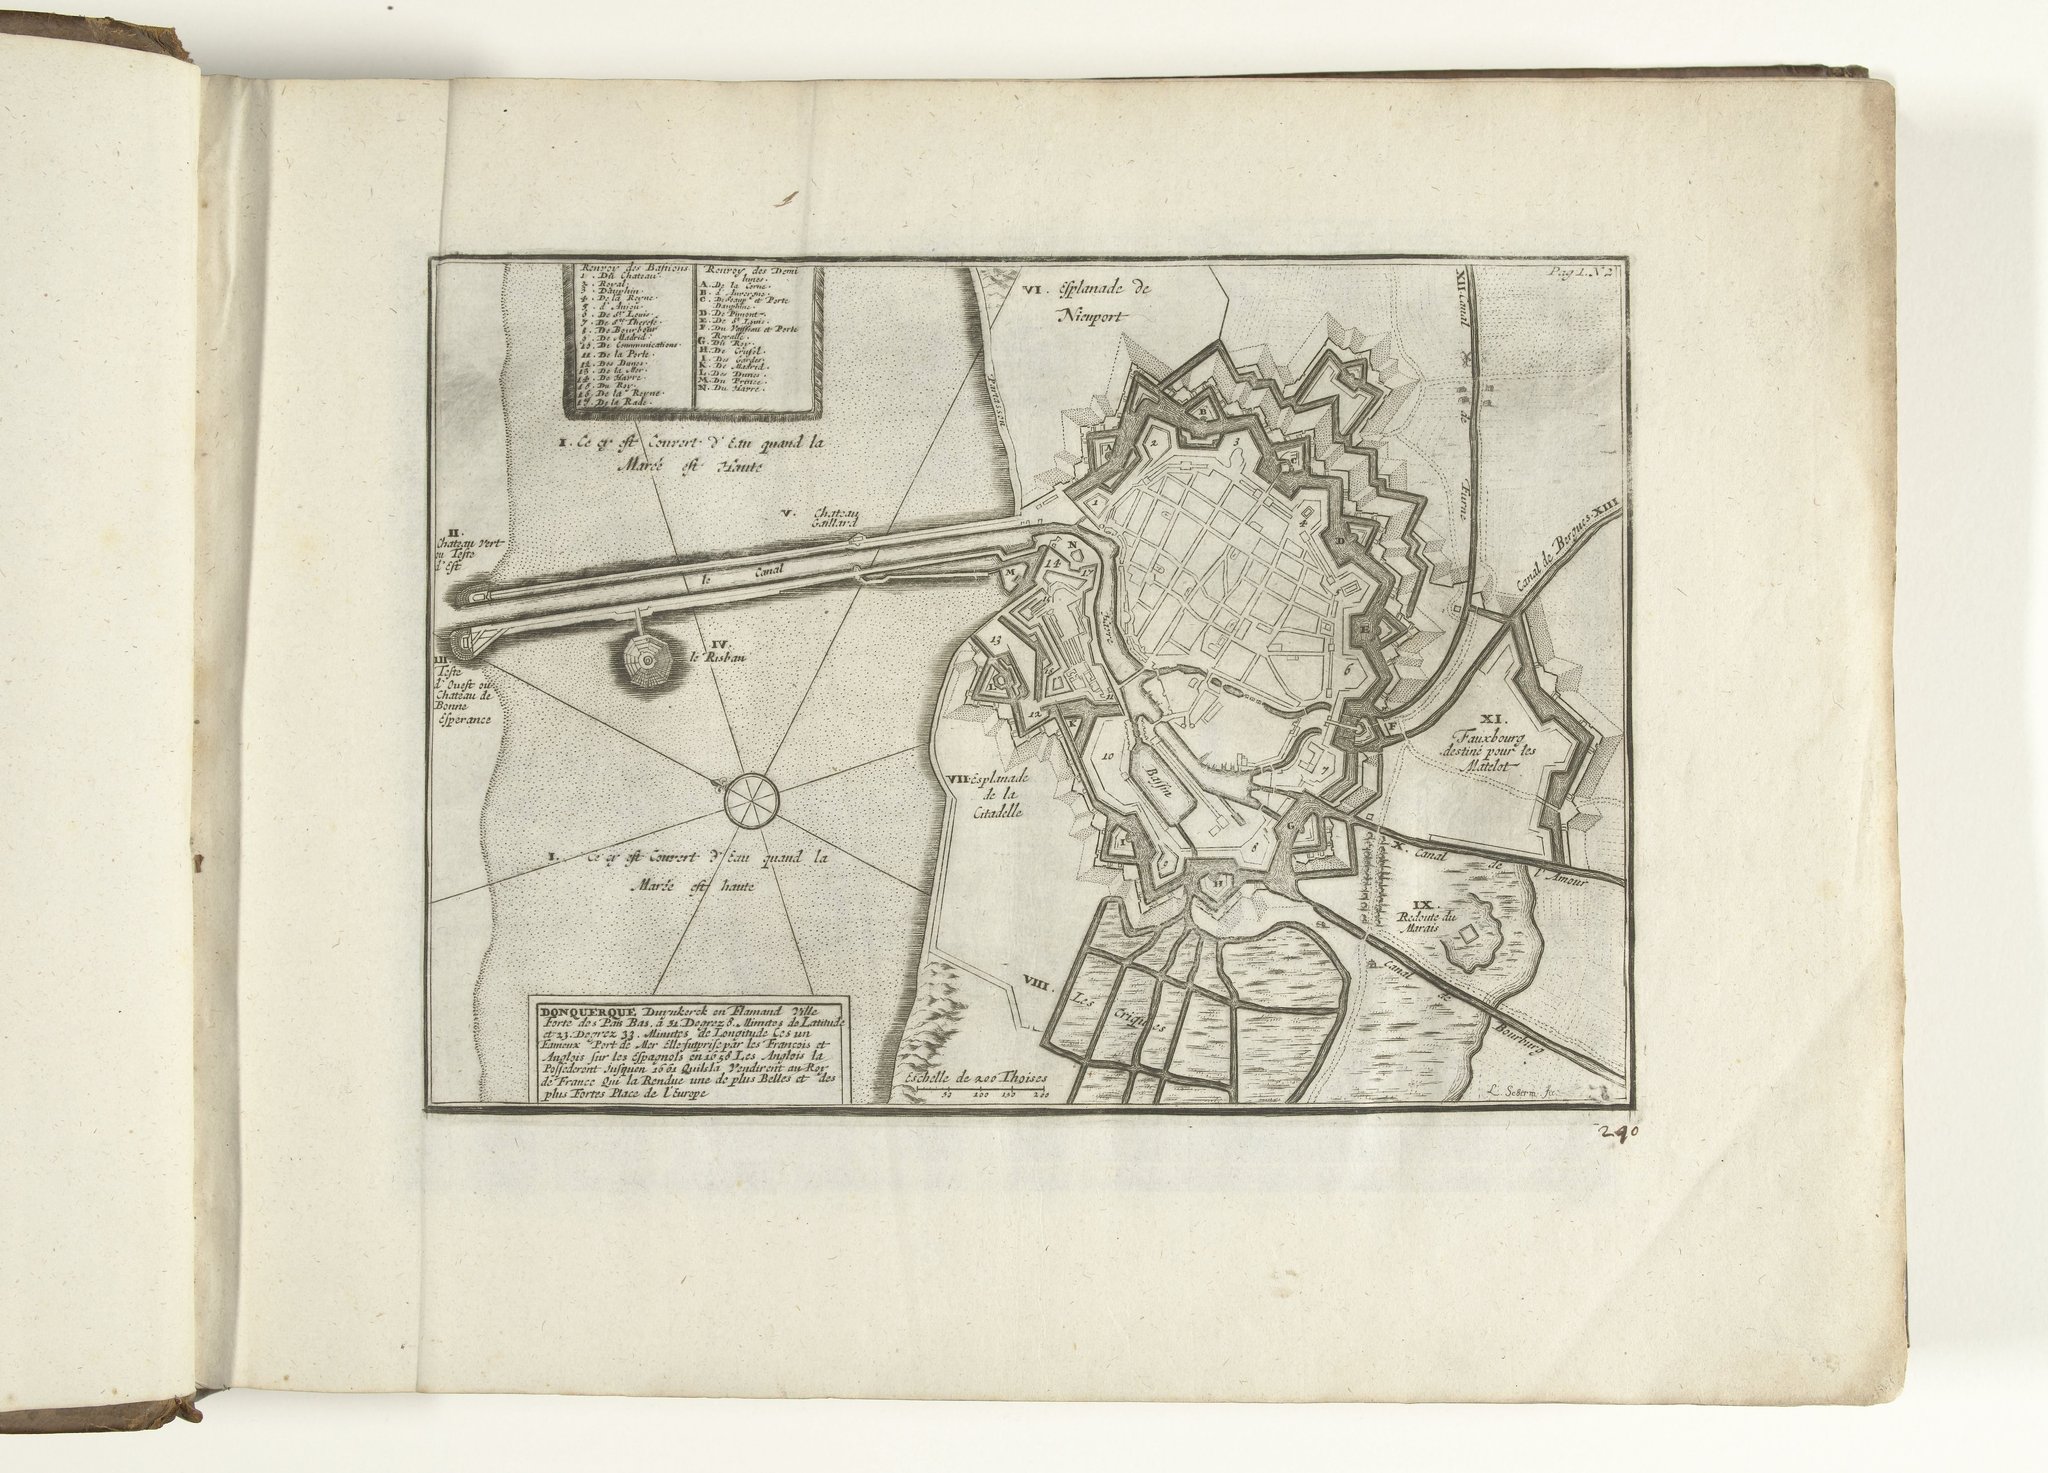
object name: map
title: Donquerque Duynkerck en Flamand Ville Forte des Pais Bas (...)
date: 1726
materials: paper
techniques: engraving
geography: leiden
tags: fortress, maps of cities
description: Plattegrond van de verdedigingswerken om de stad Duinkerke. Gemerkt rechtsboven: Pag. 1. N2. Plaat nr. 121 in deel XI van het prentwerk: Les Forces de l'Europe, Asie, Afrique et Amerique ... Comme aussi les Cartes des Côtes de France et d'Espagne uit 1726, dit tweede deel met 271 met de hand genummerde platen van vermaarde sterke steden en vestingen in het kader van de Spaanse Successieoorlog 1701-1713. Voor het merendeel zijn deze platen gekopieerd naar de anonieme Franse platen van vermaarde sterke steden en vestingen: in Les forces de l'Europe en in: Le theatre de la guerre, dans les Pays-Bas, beide oorspronkelijk uitgegeven door Nicolas de Fer te Parijs (1693-1697) in het kader van de Negenjarige Oorlog. Titel en opschriften in het Frans. Rechtsonder sporen van het weggepolijste nummer: 72.